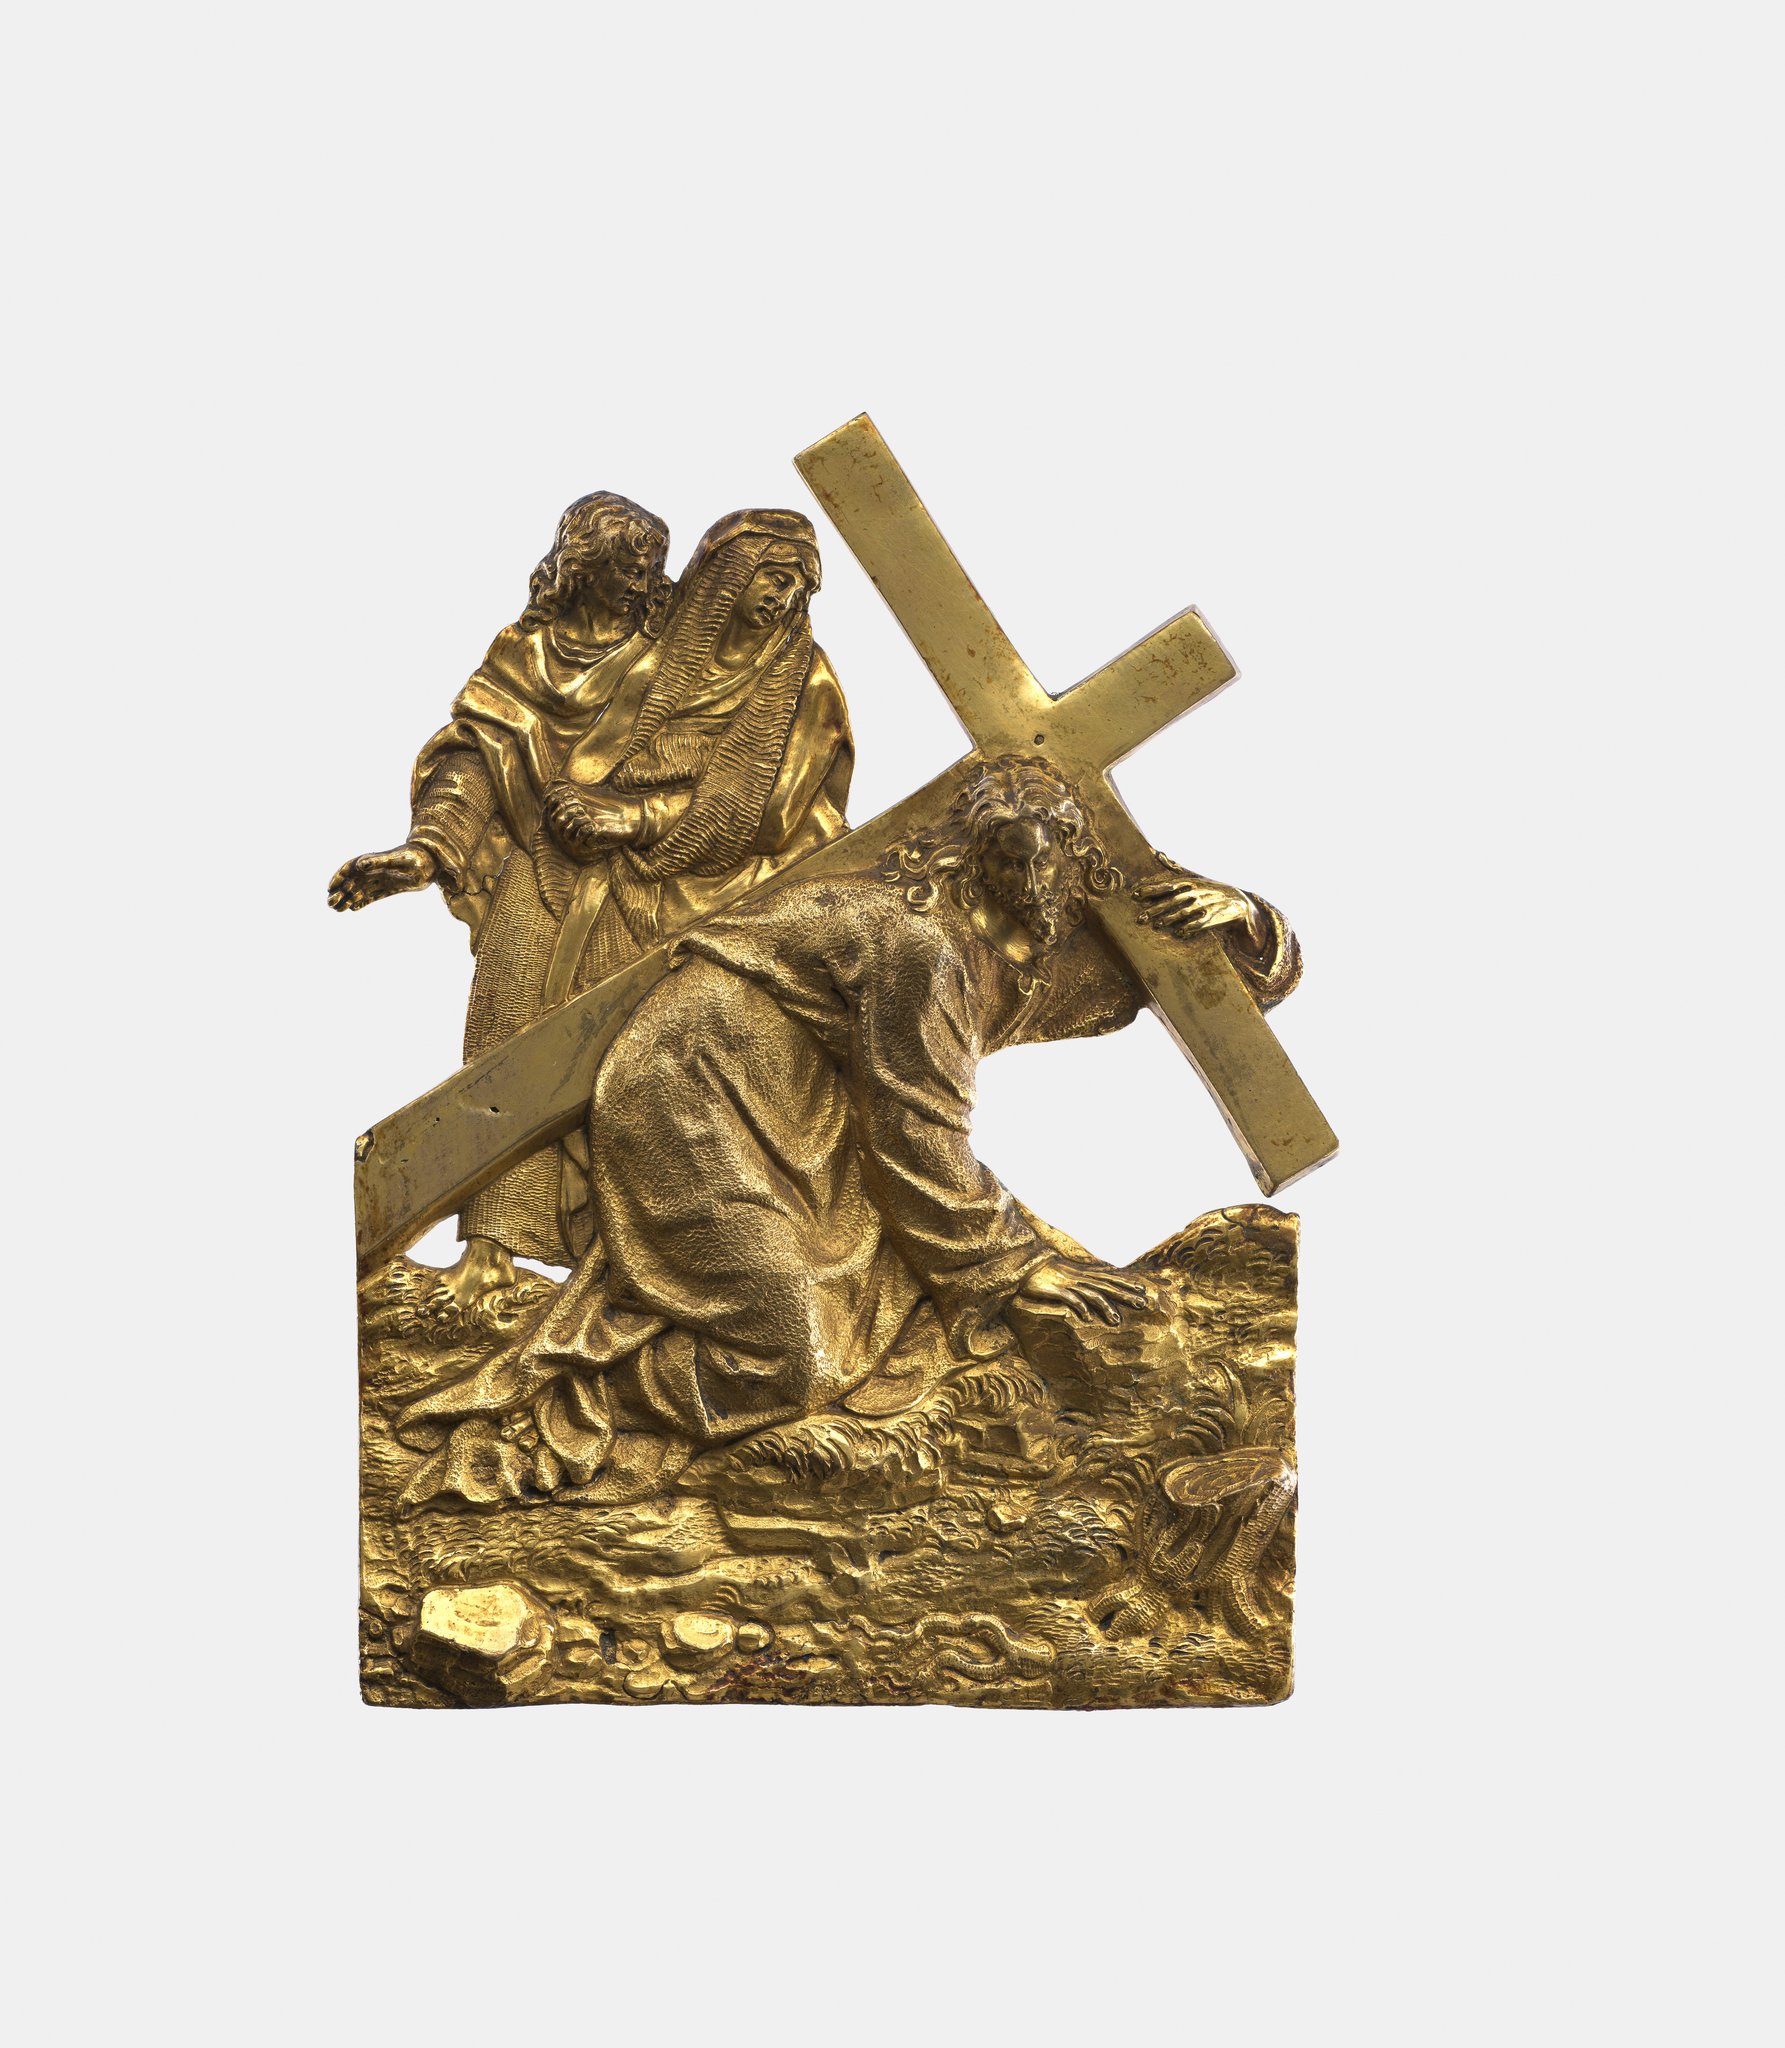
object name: plaquette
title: Christ carrying the cross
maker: Anonymous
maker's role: artist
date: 1500-1599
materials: bronze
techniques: gilding